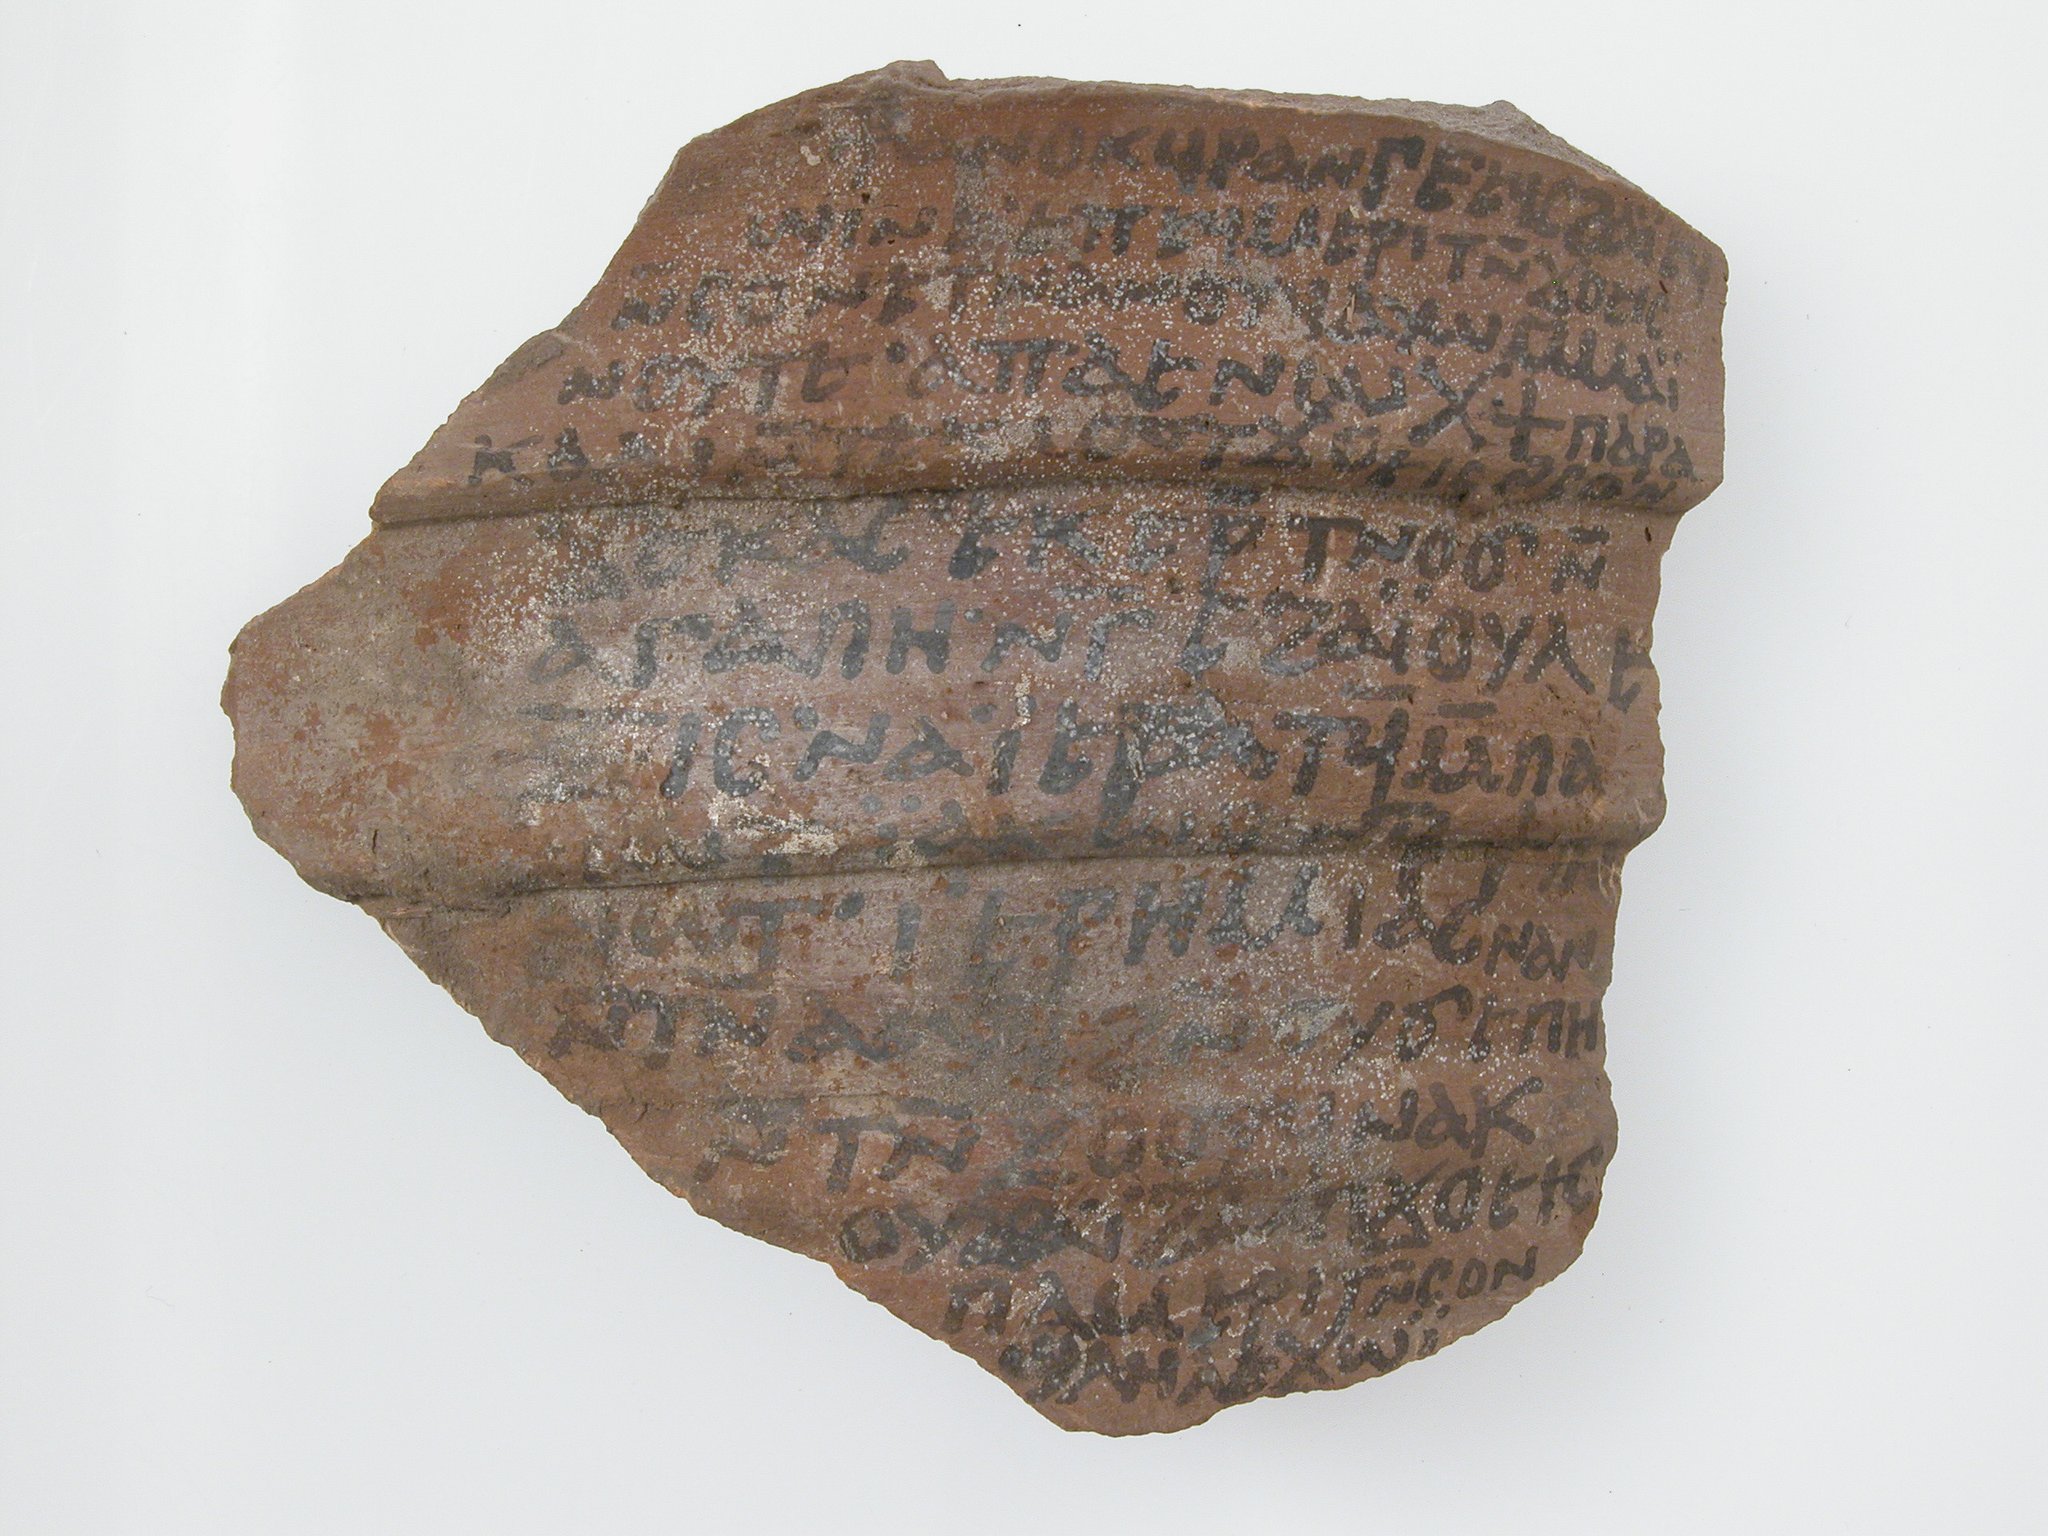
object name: ostrakon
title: Ostrakon with a Letter from Frange to Enoch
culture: coptic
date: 600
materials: ink, pottery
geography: egypt